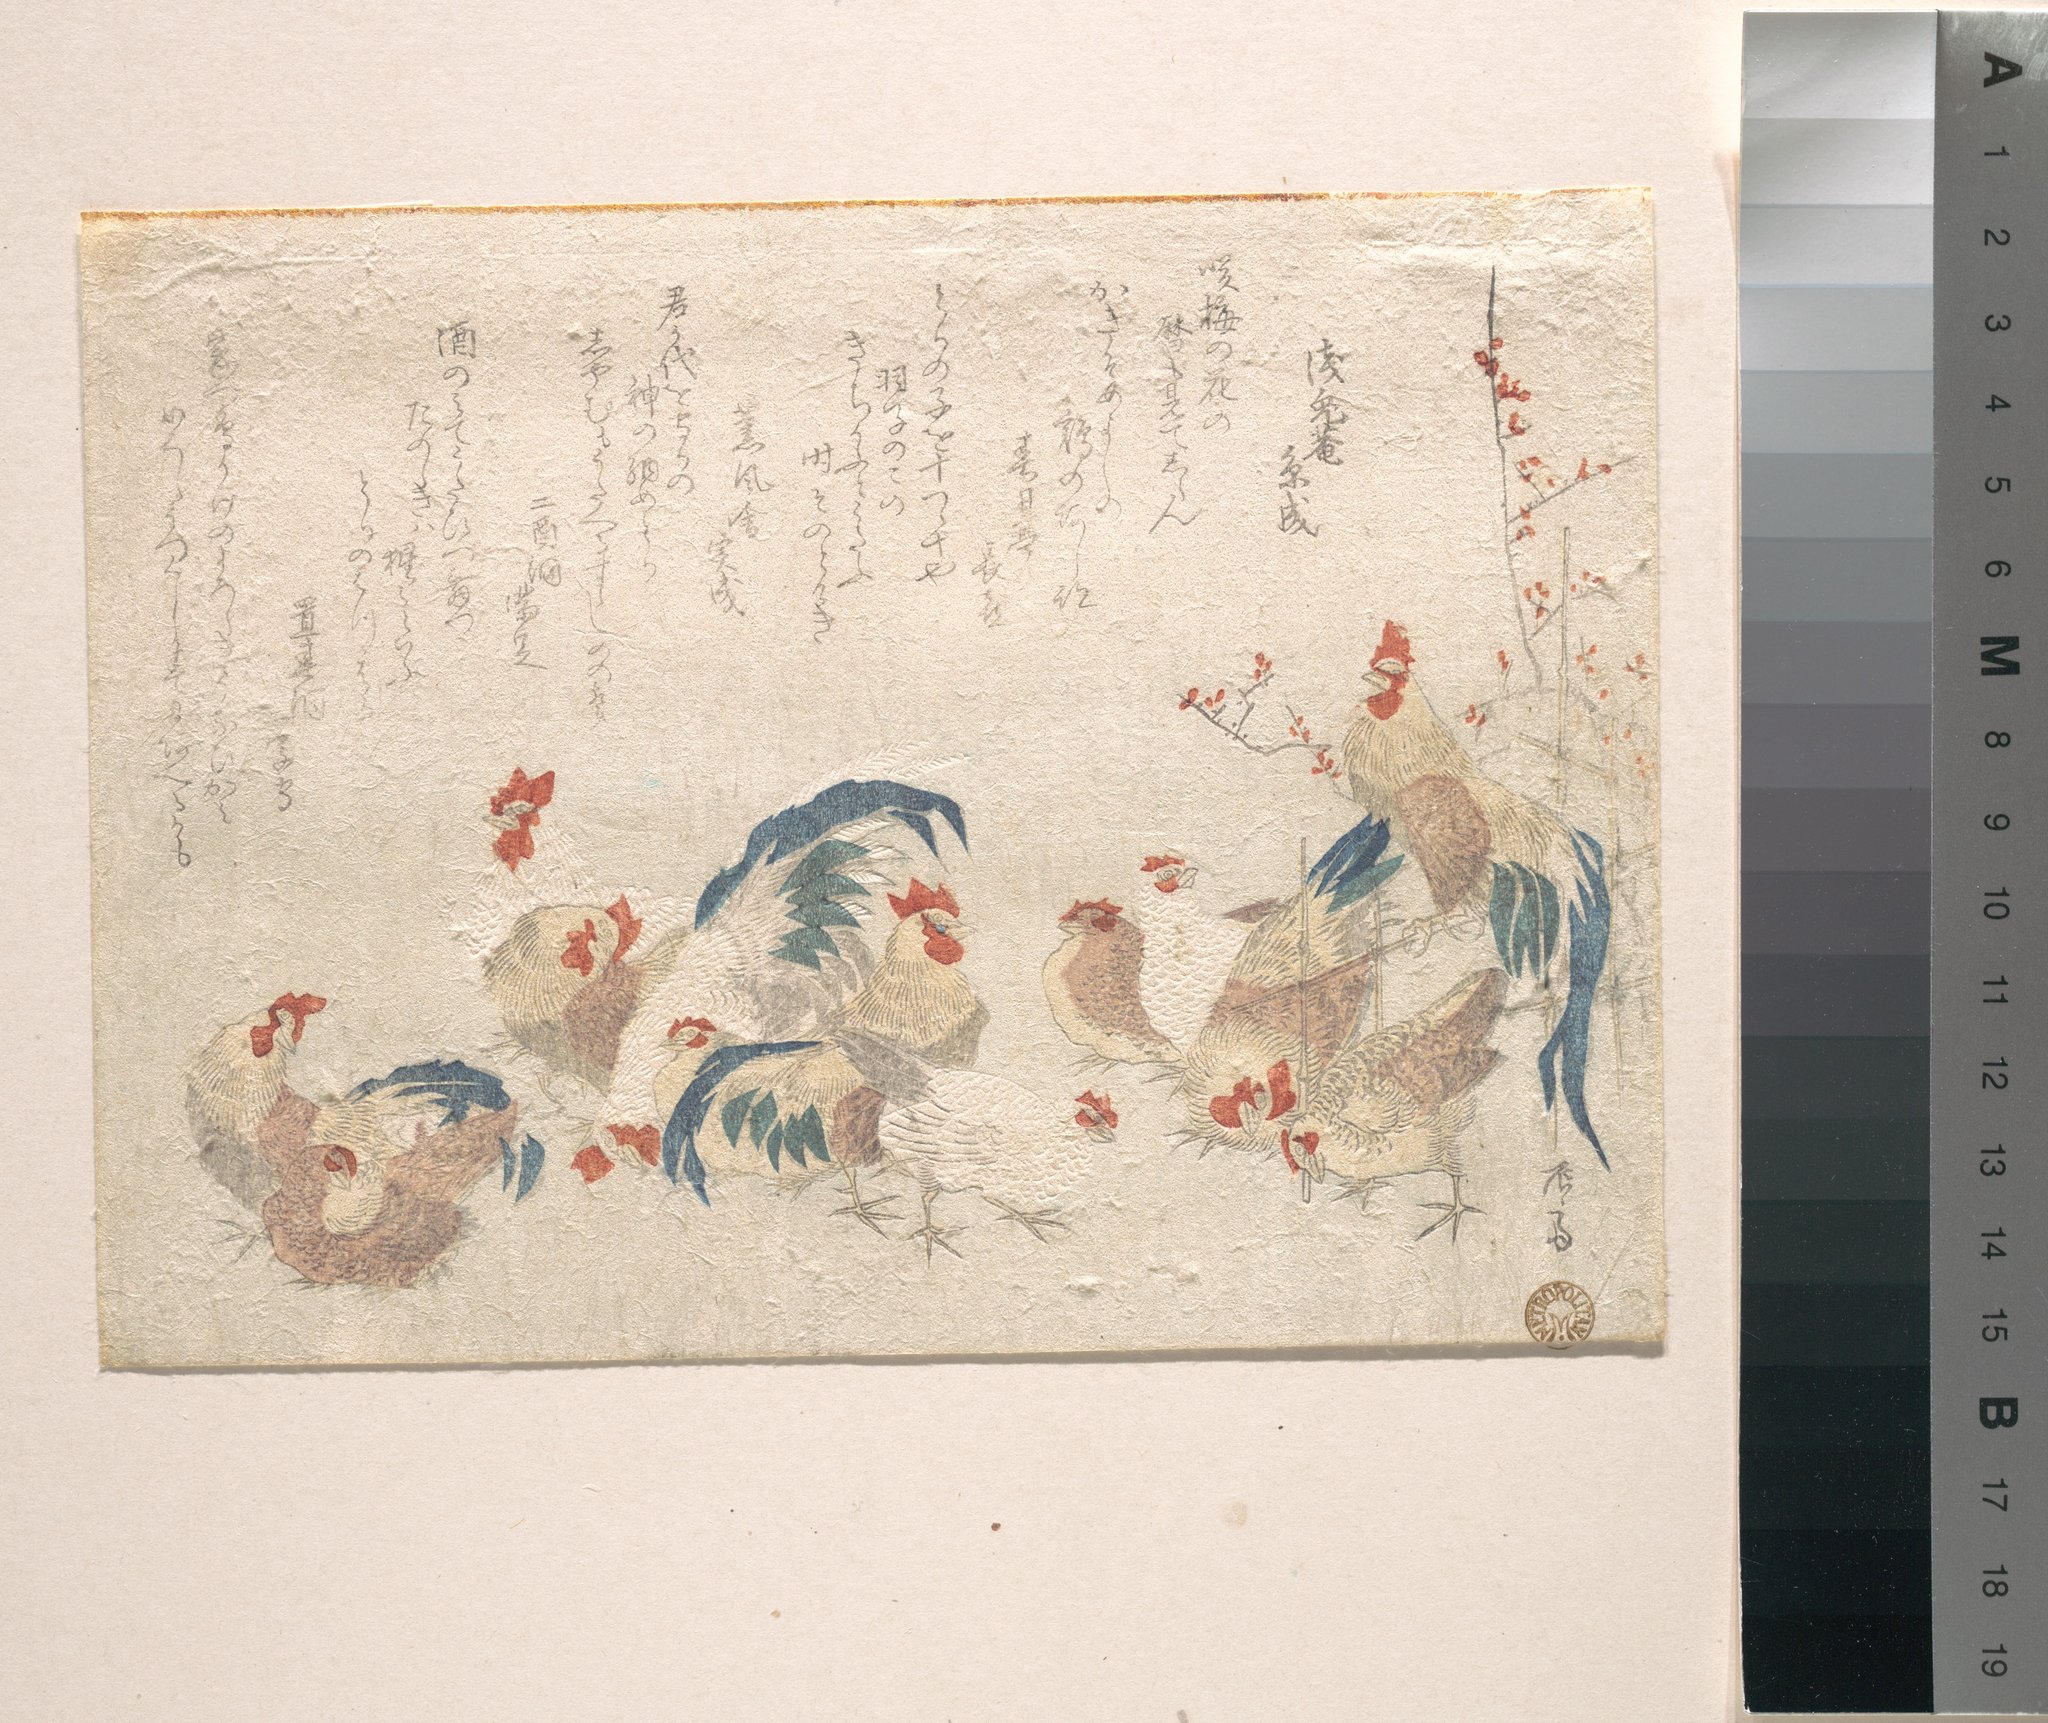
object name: print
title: Cocks and Hens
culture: japanese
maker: ryūryūkyo shinsai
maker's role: artist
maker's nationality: japanese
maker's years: 1799-1823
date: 1801-1813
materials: ink, paper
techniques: surimono, woodblock print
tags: chickens,roosters